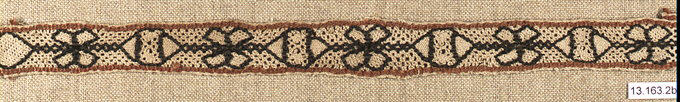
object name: insertion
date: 1601-1800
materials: linen, silk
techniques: lace